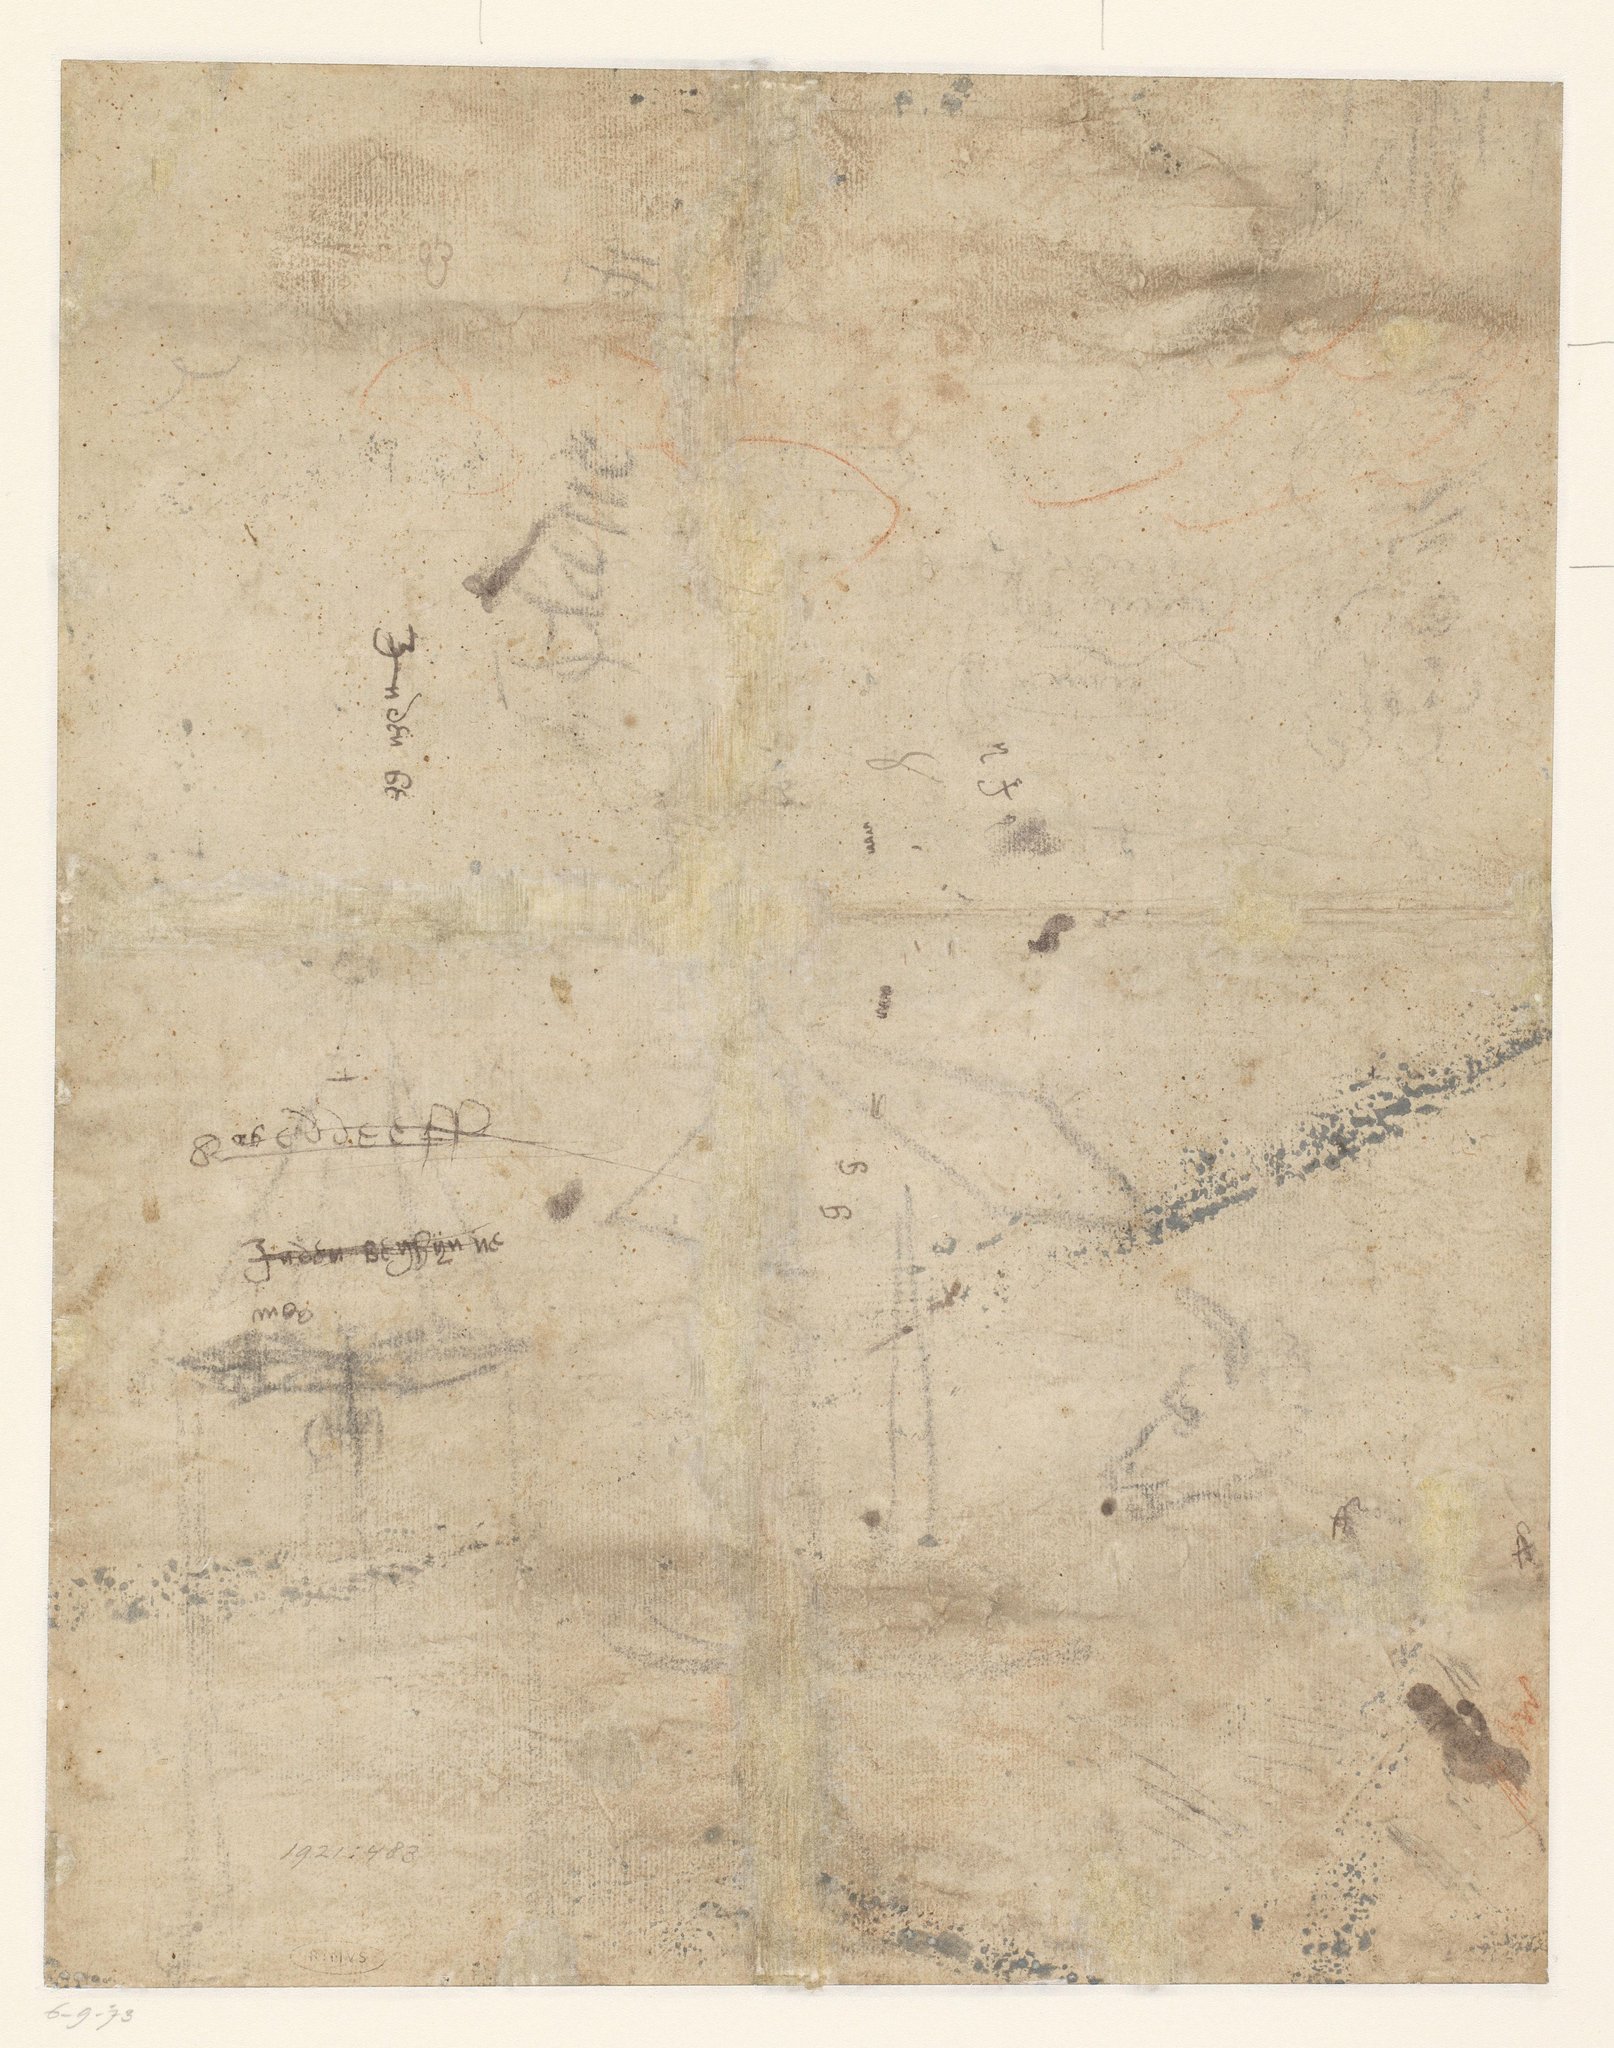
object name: drawing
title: Kleine schets van de kop van een hond (of koe?)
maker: jan swart van groningen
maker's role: draughtsman, painter, print maker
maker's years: 1500-1562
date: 1520-1560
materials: chalk, paper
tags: dog